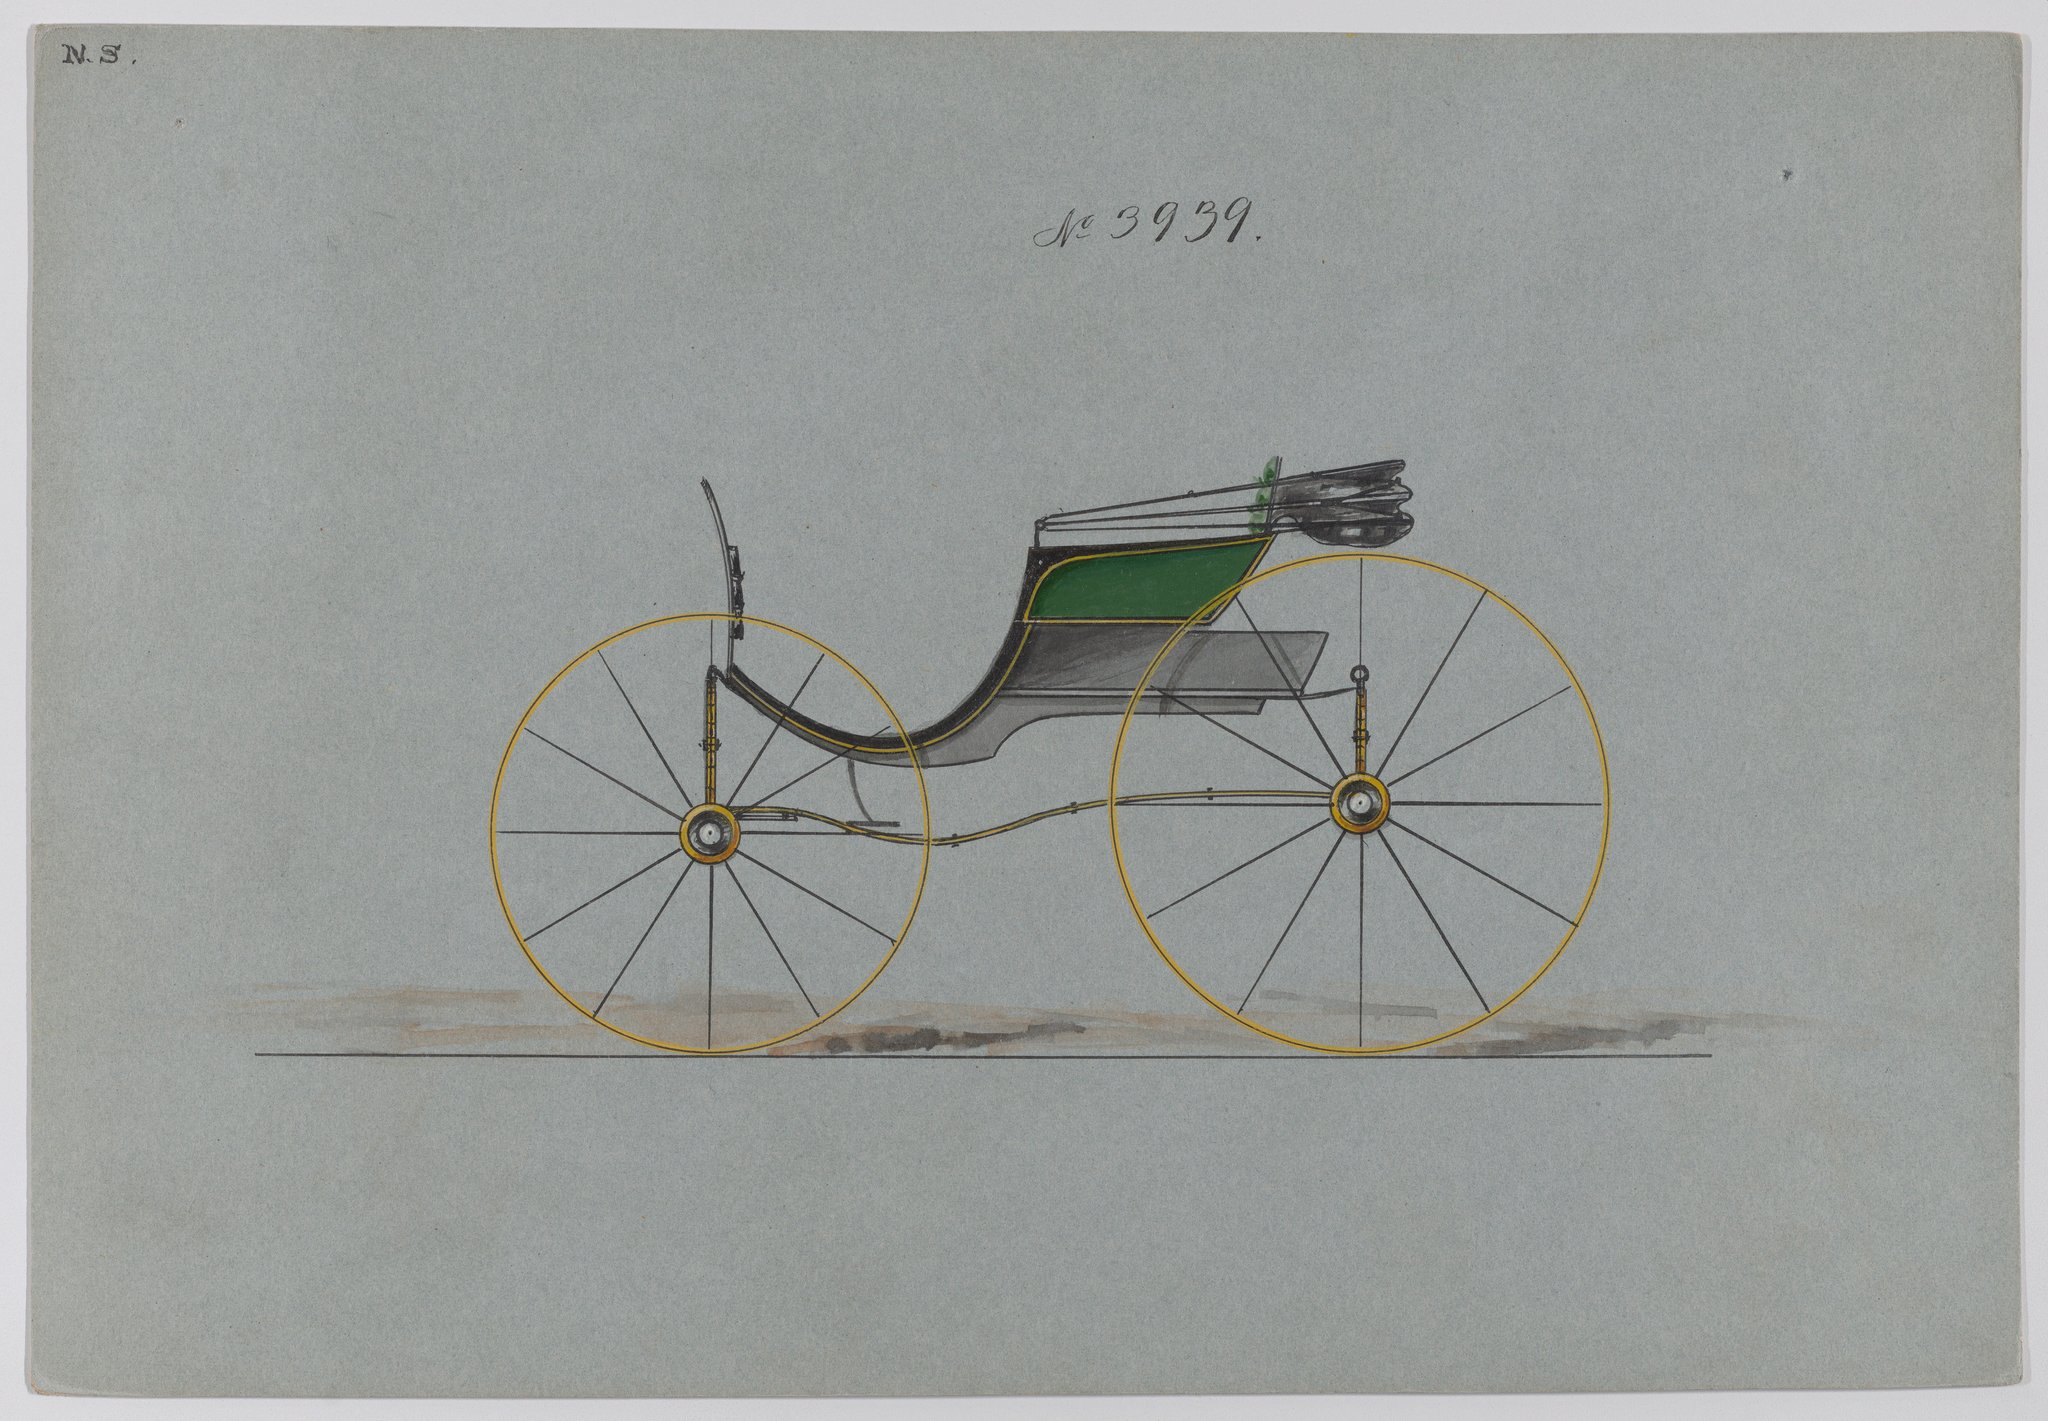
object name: drawing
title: Design for a Britton Wagon, no. 3939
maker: brewster & co.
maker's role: manufacturer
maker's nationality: american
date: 1885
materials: gouache, gum arabic, ink, watercolor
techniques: pen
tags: carriages